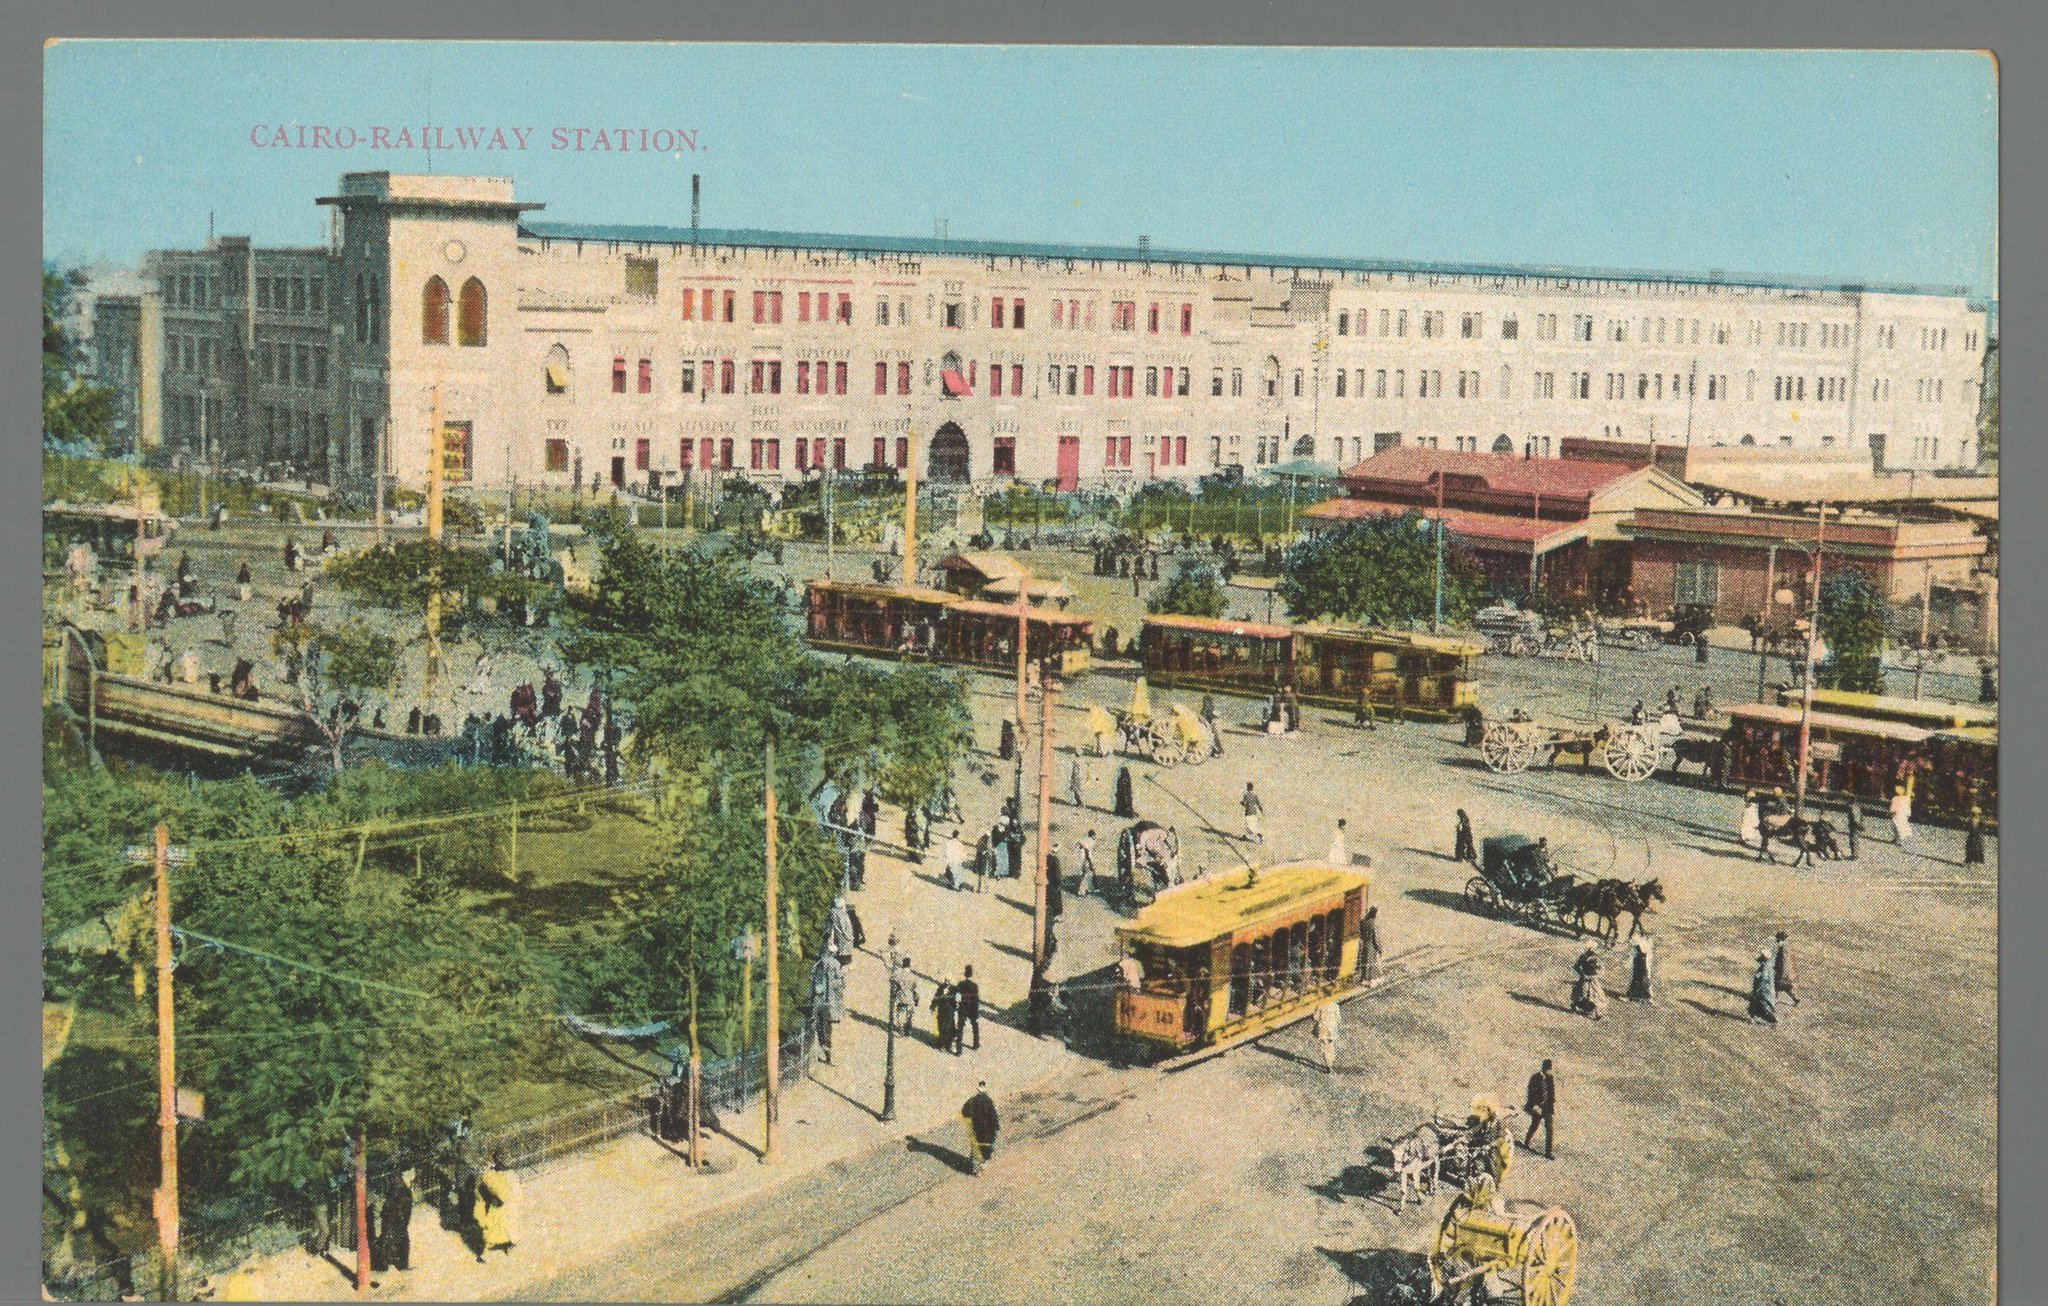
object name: photomechanical print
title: Cairo-railway Station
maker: Anonymous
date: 1907-1930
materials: cardboard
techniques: lithograph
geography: cairo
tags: station; shelter (railway, tramway)